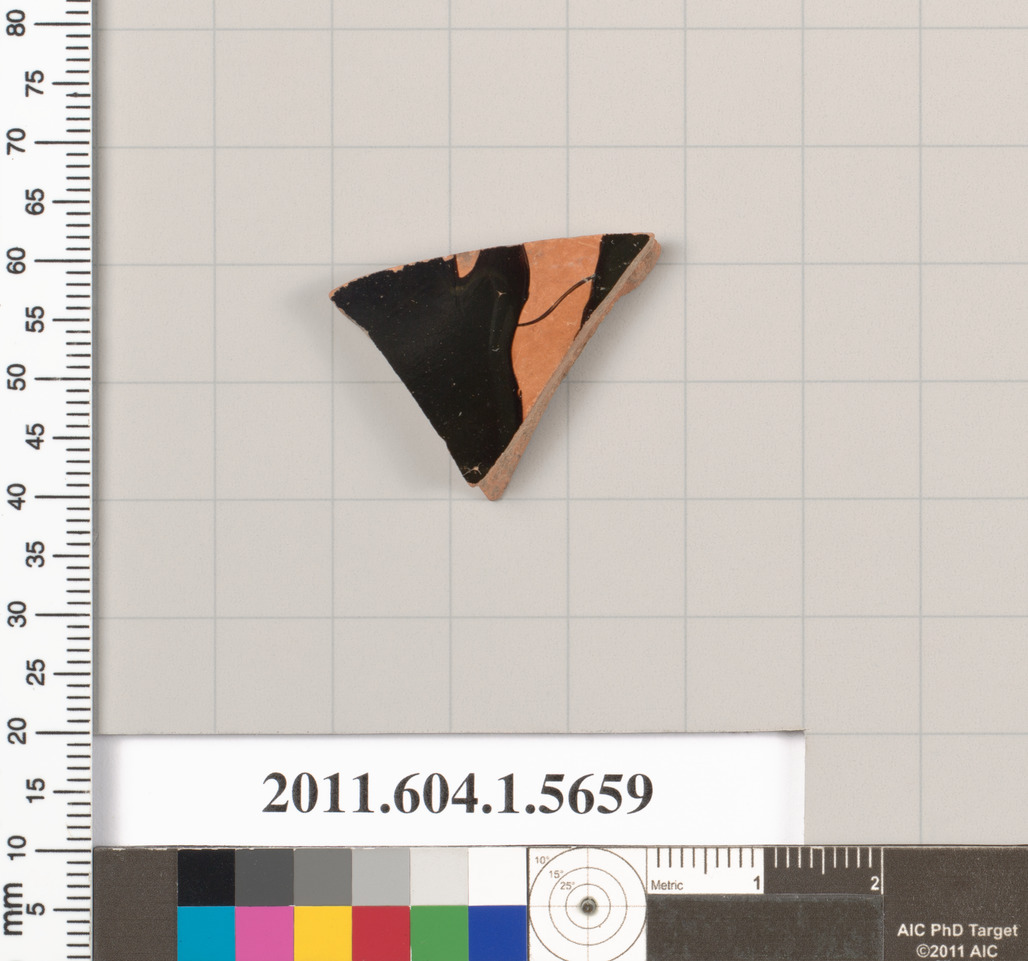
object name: kylix fragment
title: Terracotta fragment of a kylix (drinking cup)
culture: greek, attic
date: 500-480 BCE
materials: terracotta